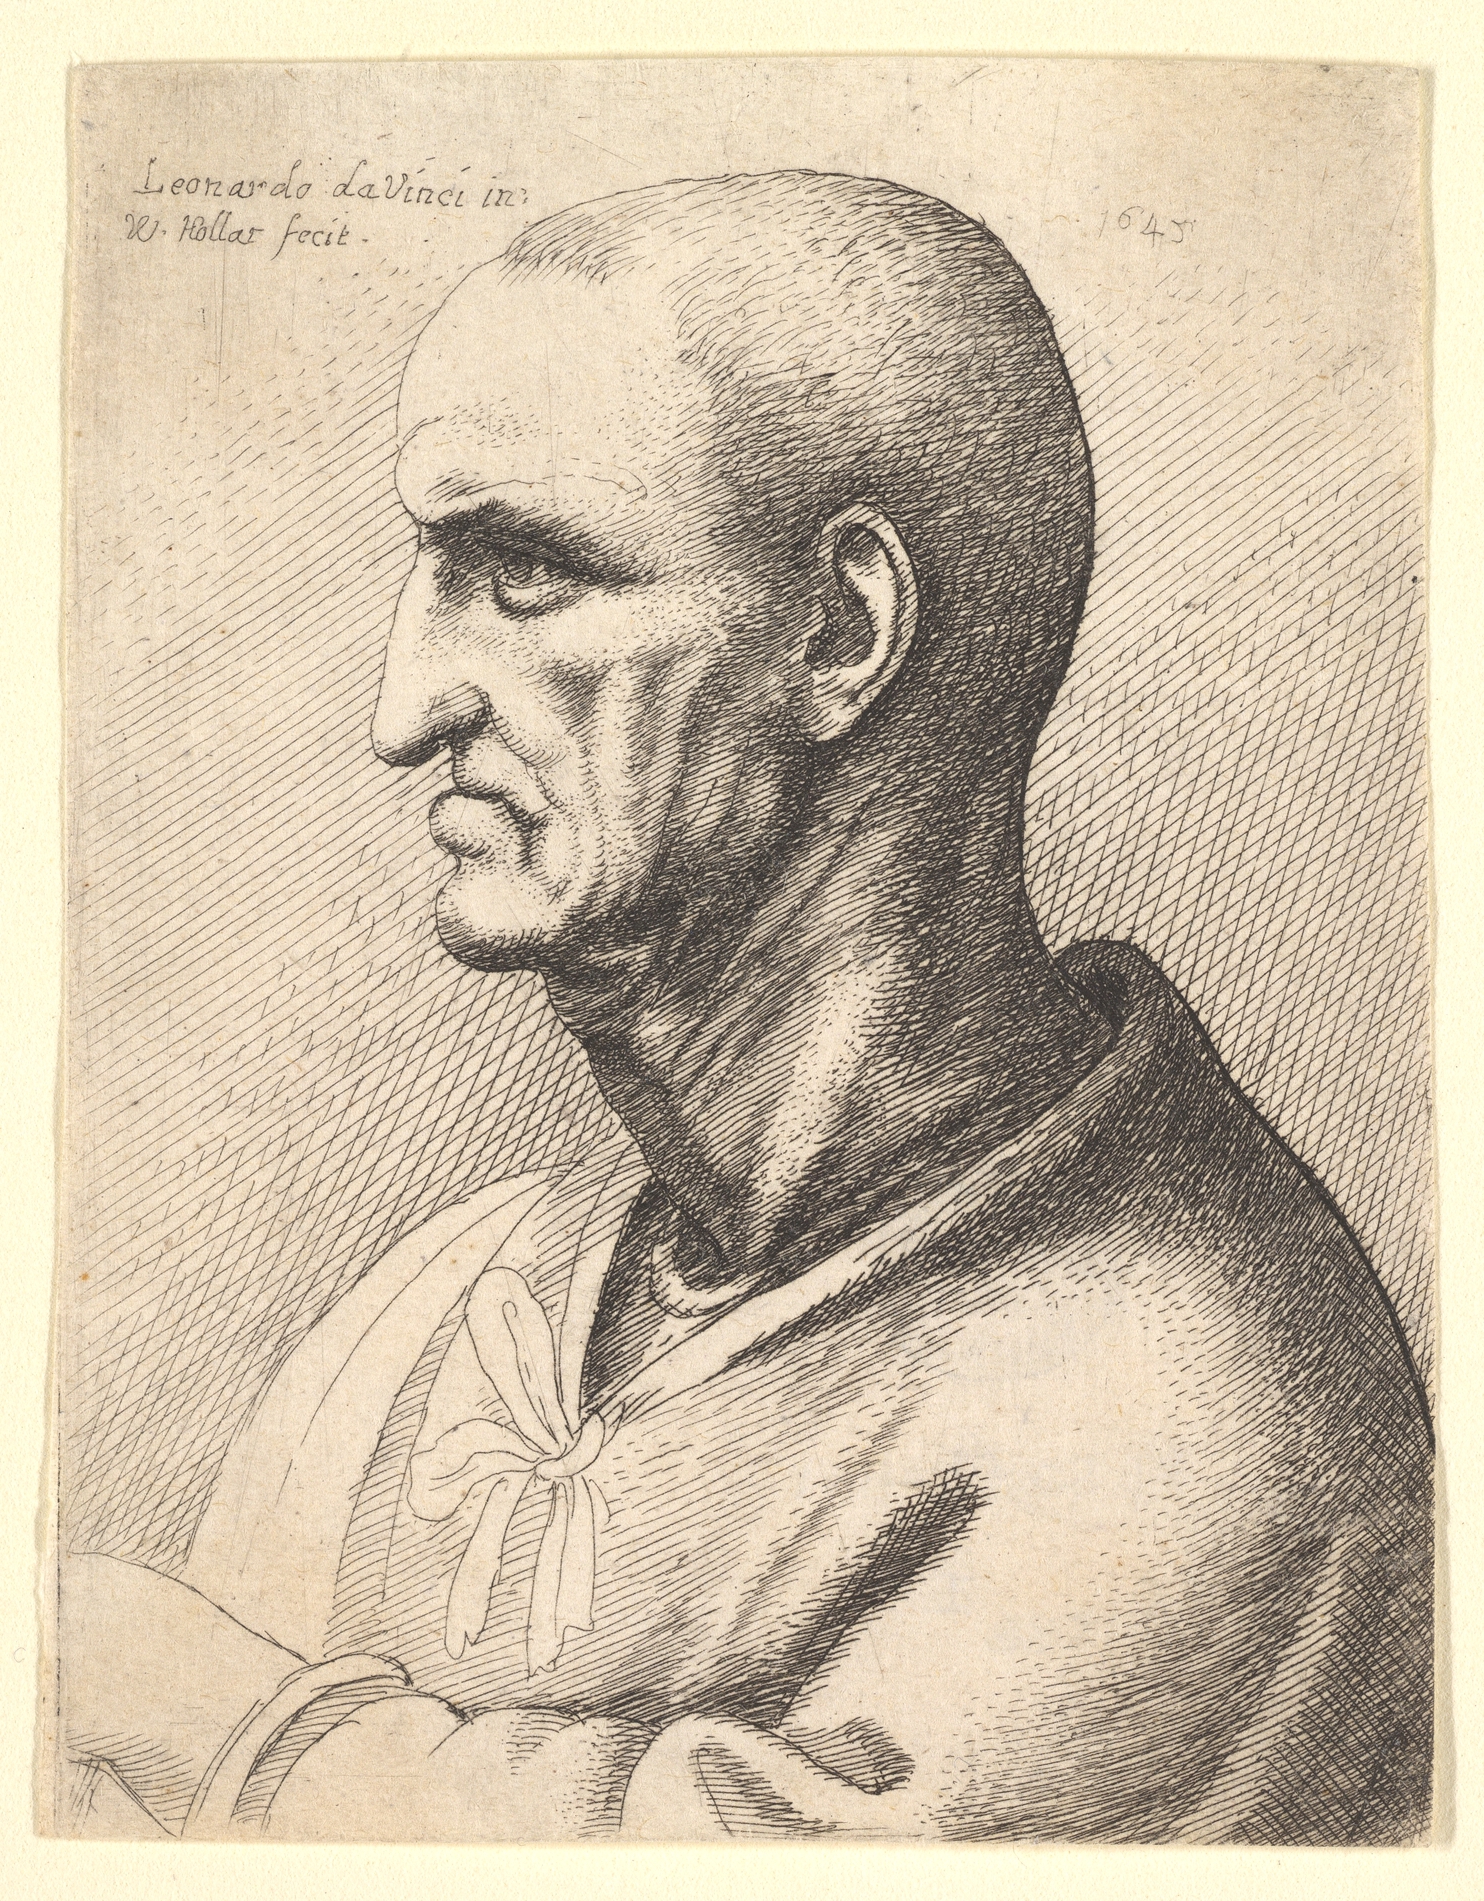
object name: print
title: Man with stern expression in profile to left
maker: wenceslaus hollar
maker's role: artist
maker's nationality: bohemian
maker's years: 1607-1677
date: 1645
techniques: etching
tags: men